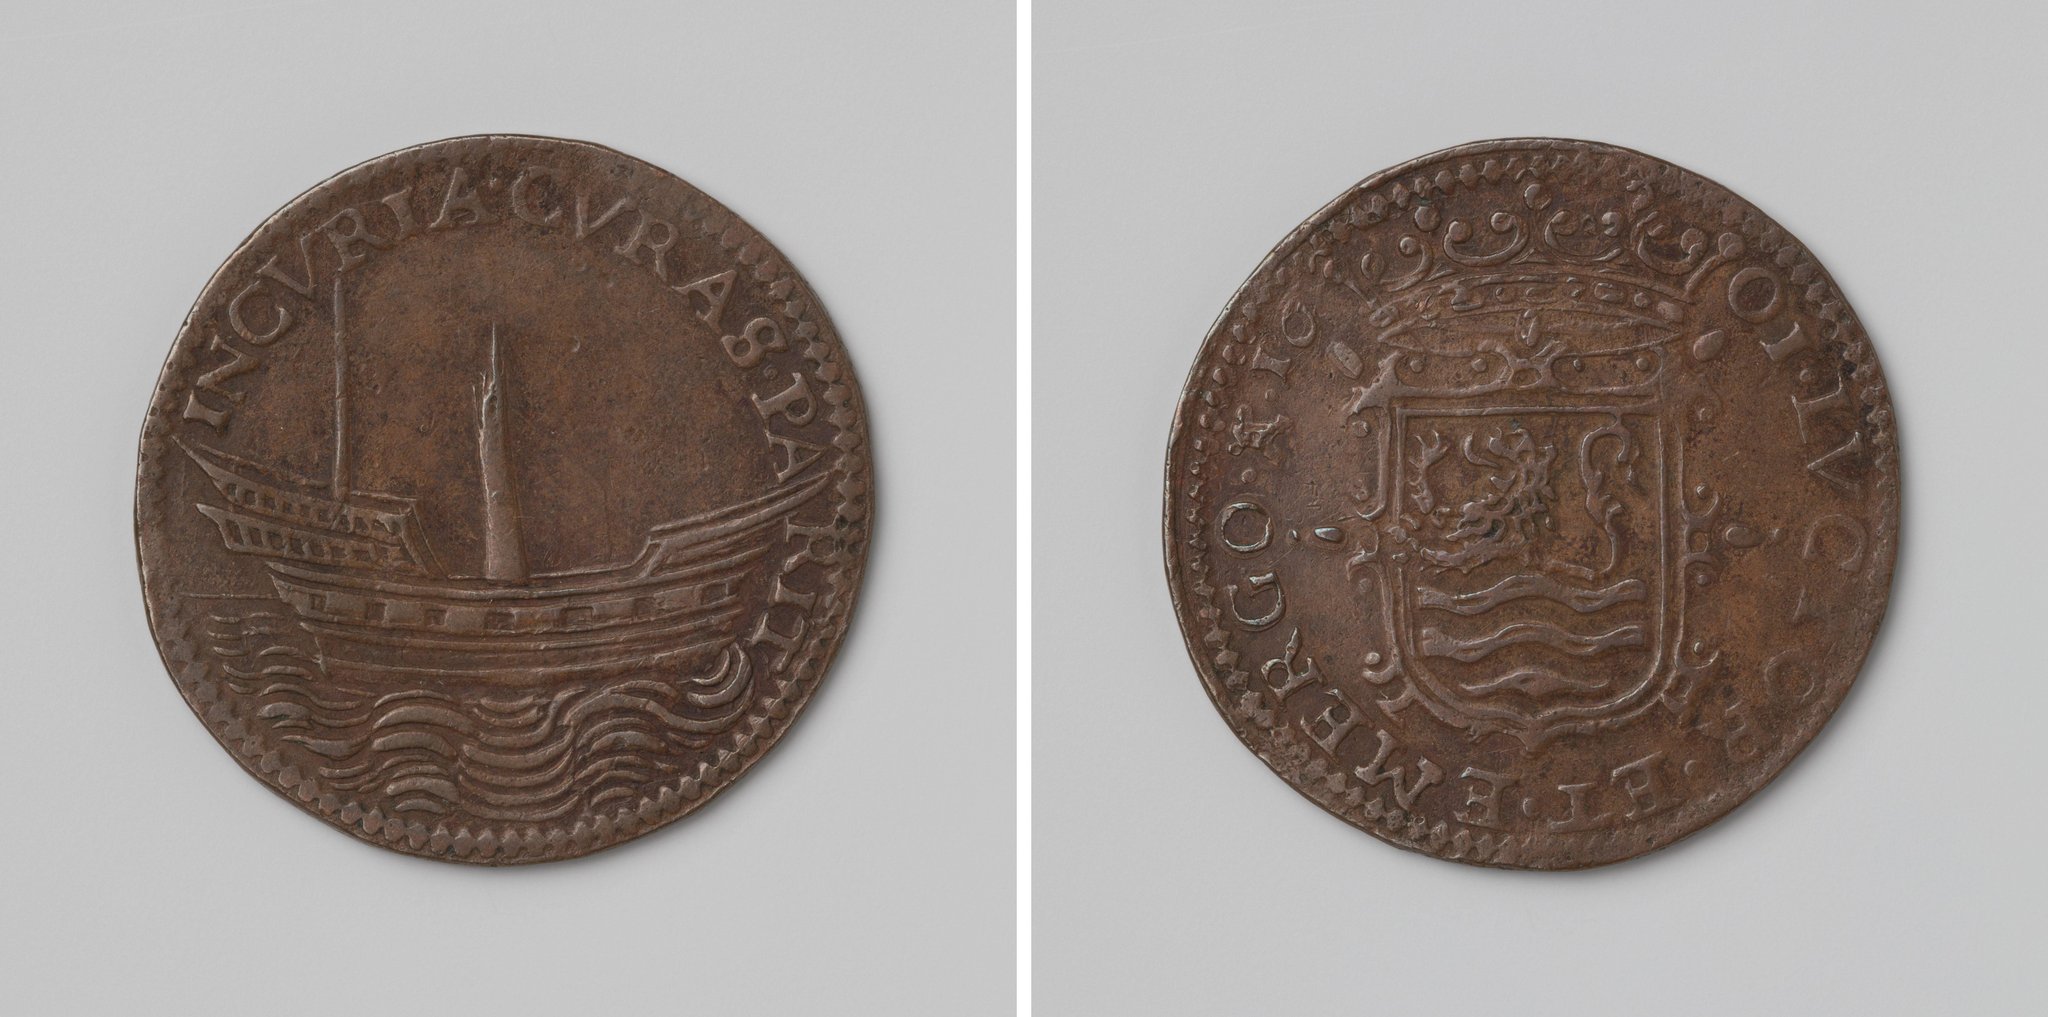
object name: jeton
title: Krijgstoerustingen in de Republiek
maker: Anonymous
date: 1601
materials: copper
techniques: striking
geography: middelburg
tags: netherlands, zeeland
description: Koperen penning. Voorzijde: roerloos schip met afgebroken mast binnen omschrift. Keerzijde: gekroond wapenschild in cartouche binnen omschrift